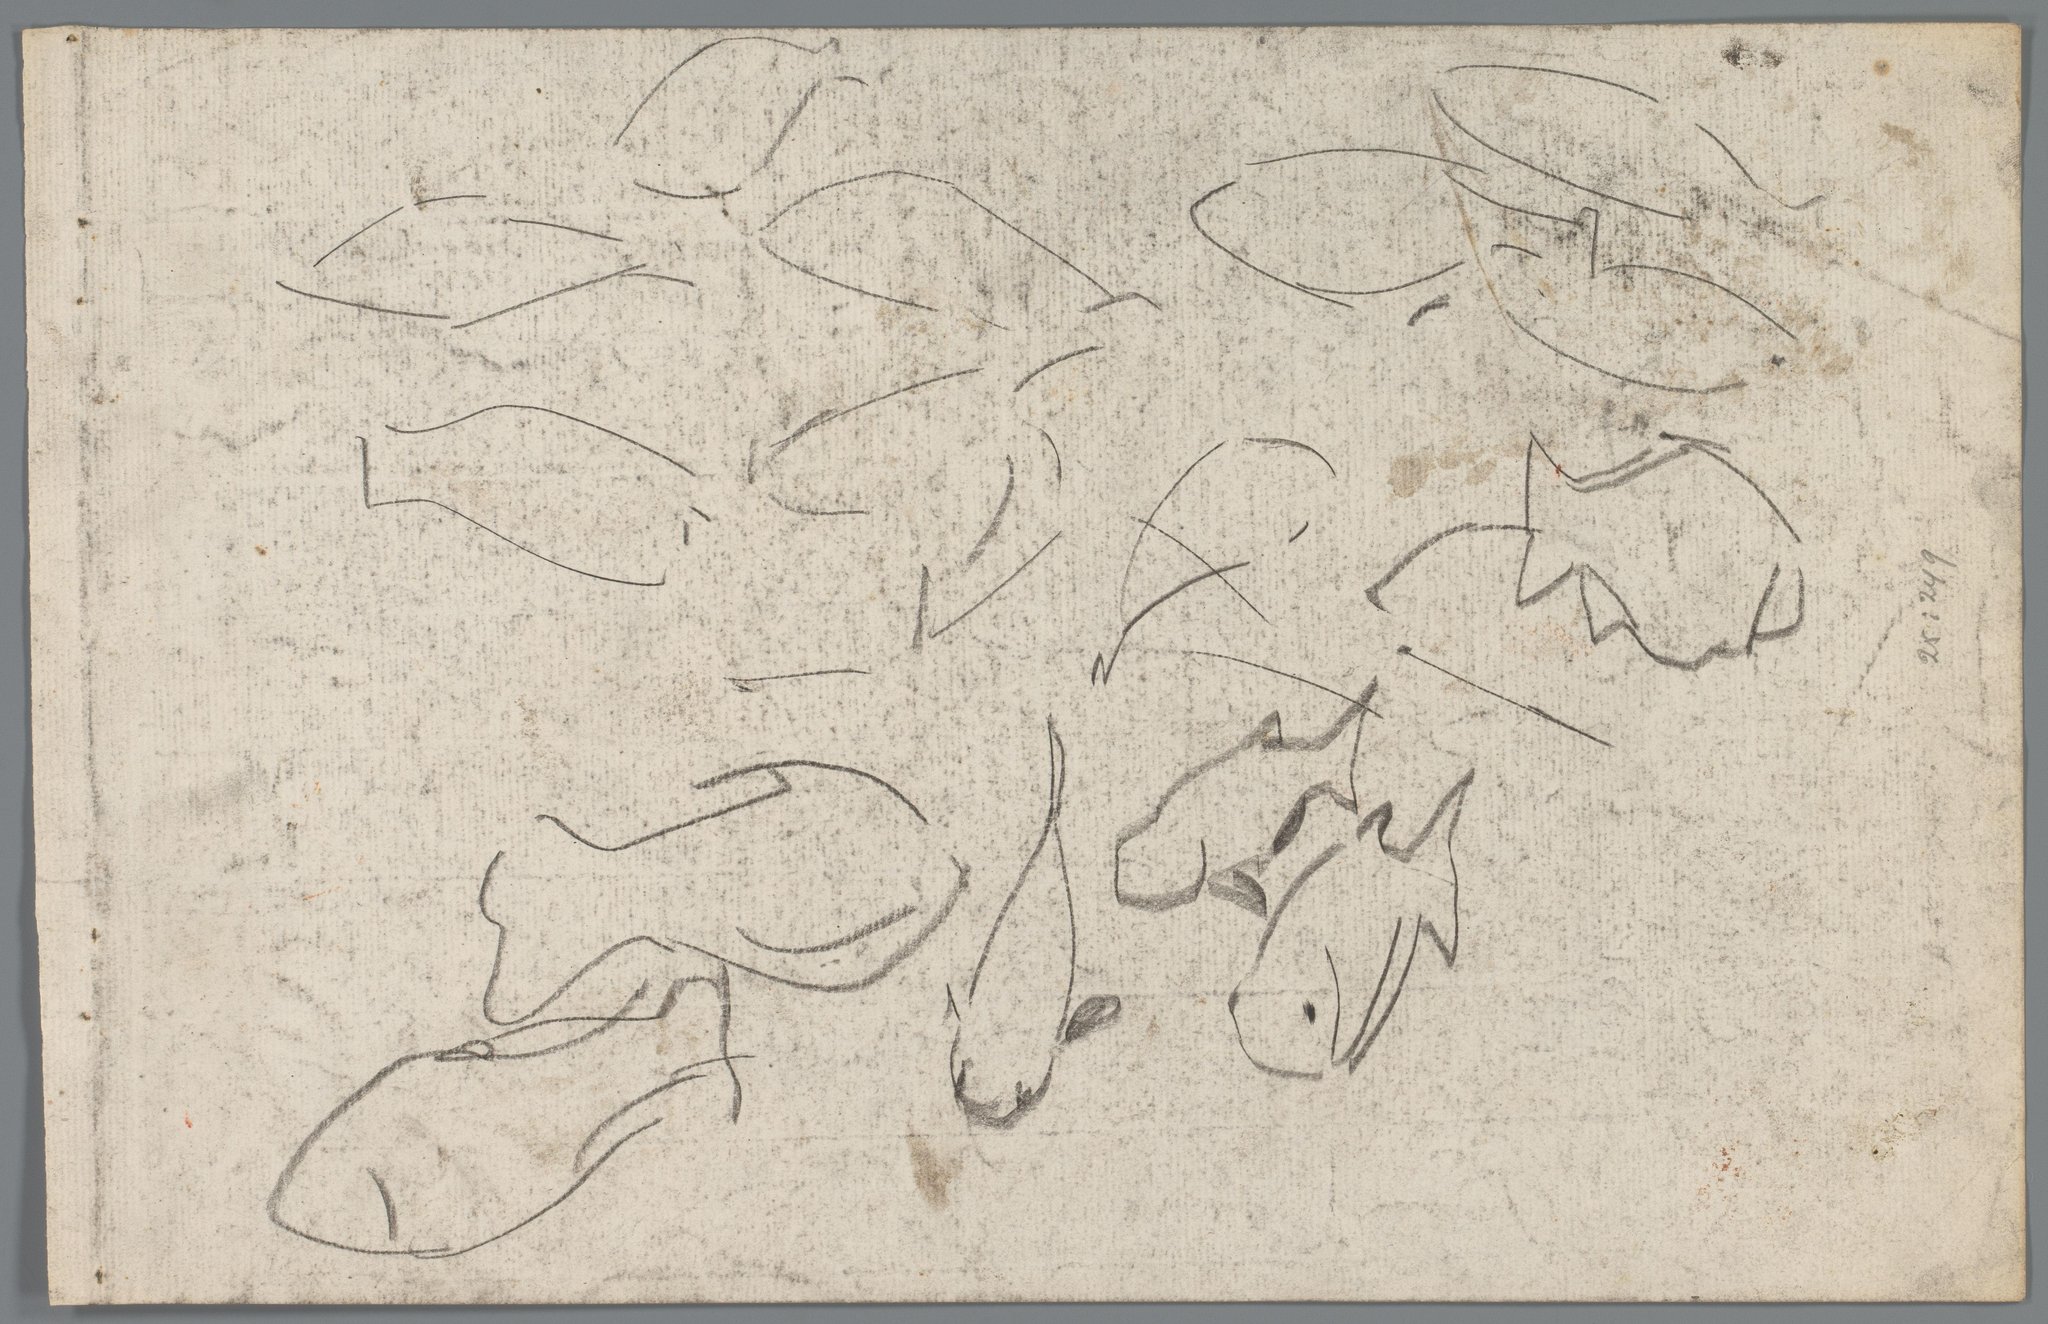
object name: drawing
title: Studieblad met vissen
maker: gerrit willem dijsselhof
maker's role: designer, draughtsman, print maker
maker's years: 1866-1924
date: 1876-1924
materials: chalk, paper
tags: bony fishes